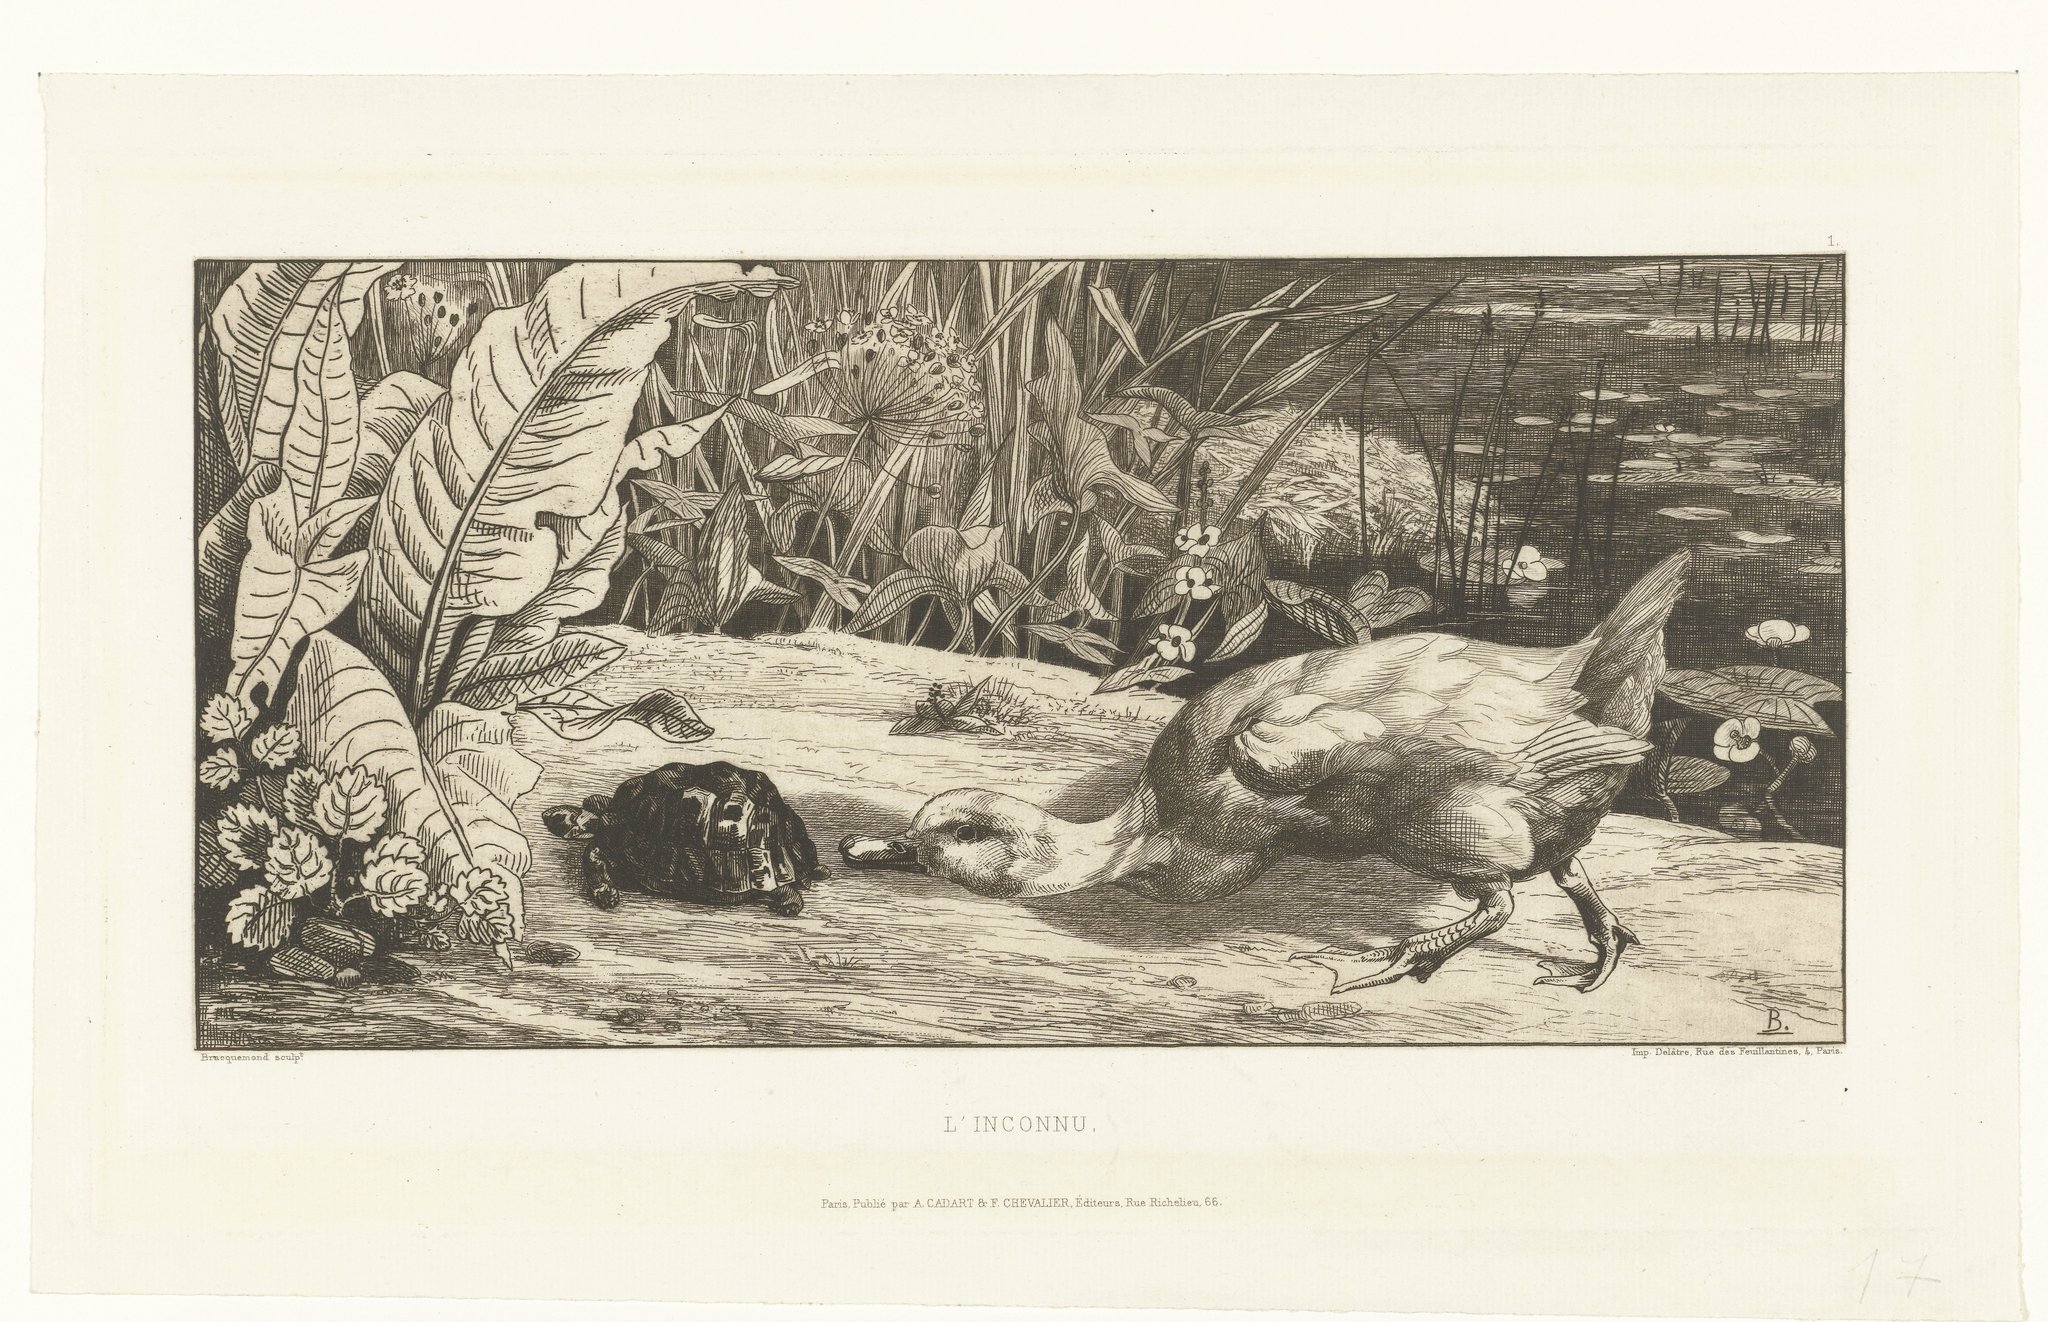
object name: print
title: Eend en schildpad op oever van sloot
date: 1860-1865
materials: paper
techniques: etching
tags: tortoises, turtles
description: Een eend loopt achter een schildpad aan op de oever van een sloot. In het water groeien allerlei goed herkenbare planten zoals een zwanenbloem en gele plomp.